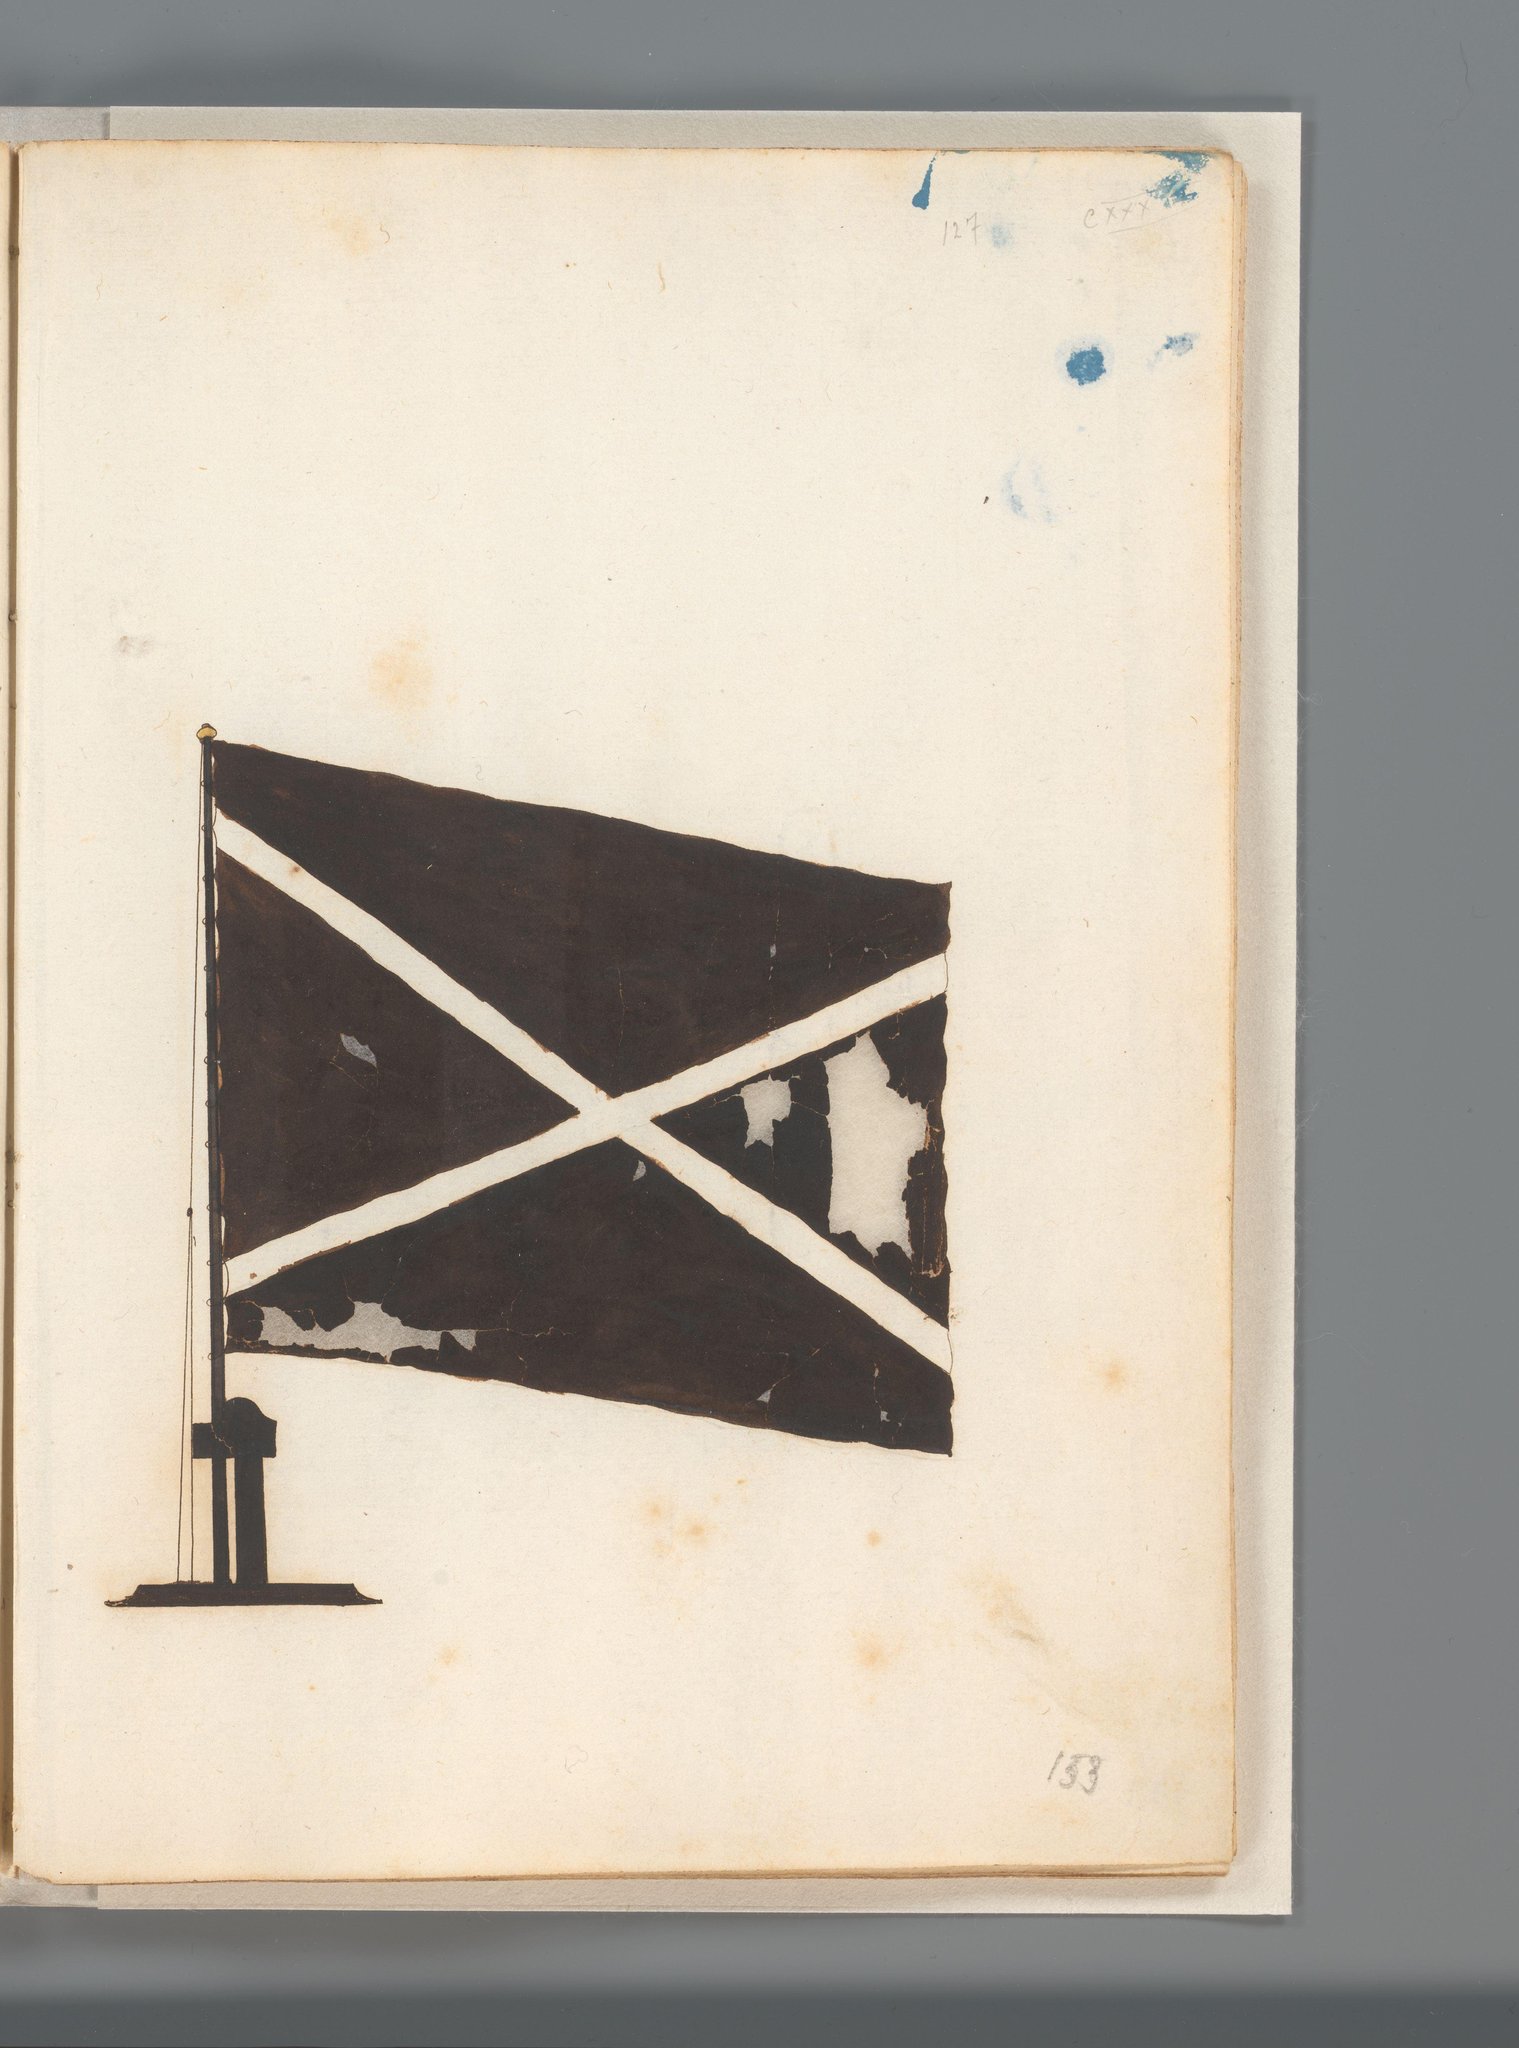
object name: drawing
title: Vlag van Rusland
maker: Anonymous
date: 1667-1670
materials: ink, paper, watercolor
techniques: brush, pen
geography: france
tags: flag, colours (as symbol of the state, etc.), russia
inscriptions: number: ‘127 / CXXXIII / 133’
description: Vlag van Rusland met een wit andreaskruis op een zwart veld. Vlag op vlaggensteng en mastvoet. Afgebeeld op folio 67r. Onderdeel van een vlaggenboek met vlaggen uit Europa, Noord-Afrika, Nabije en Verre Oosten.